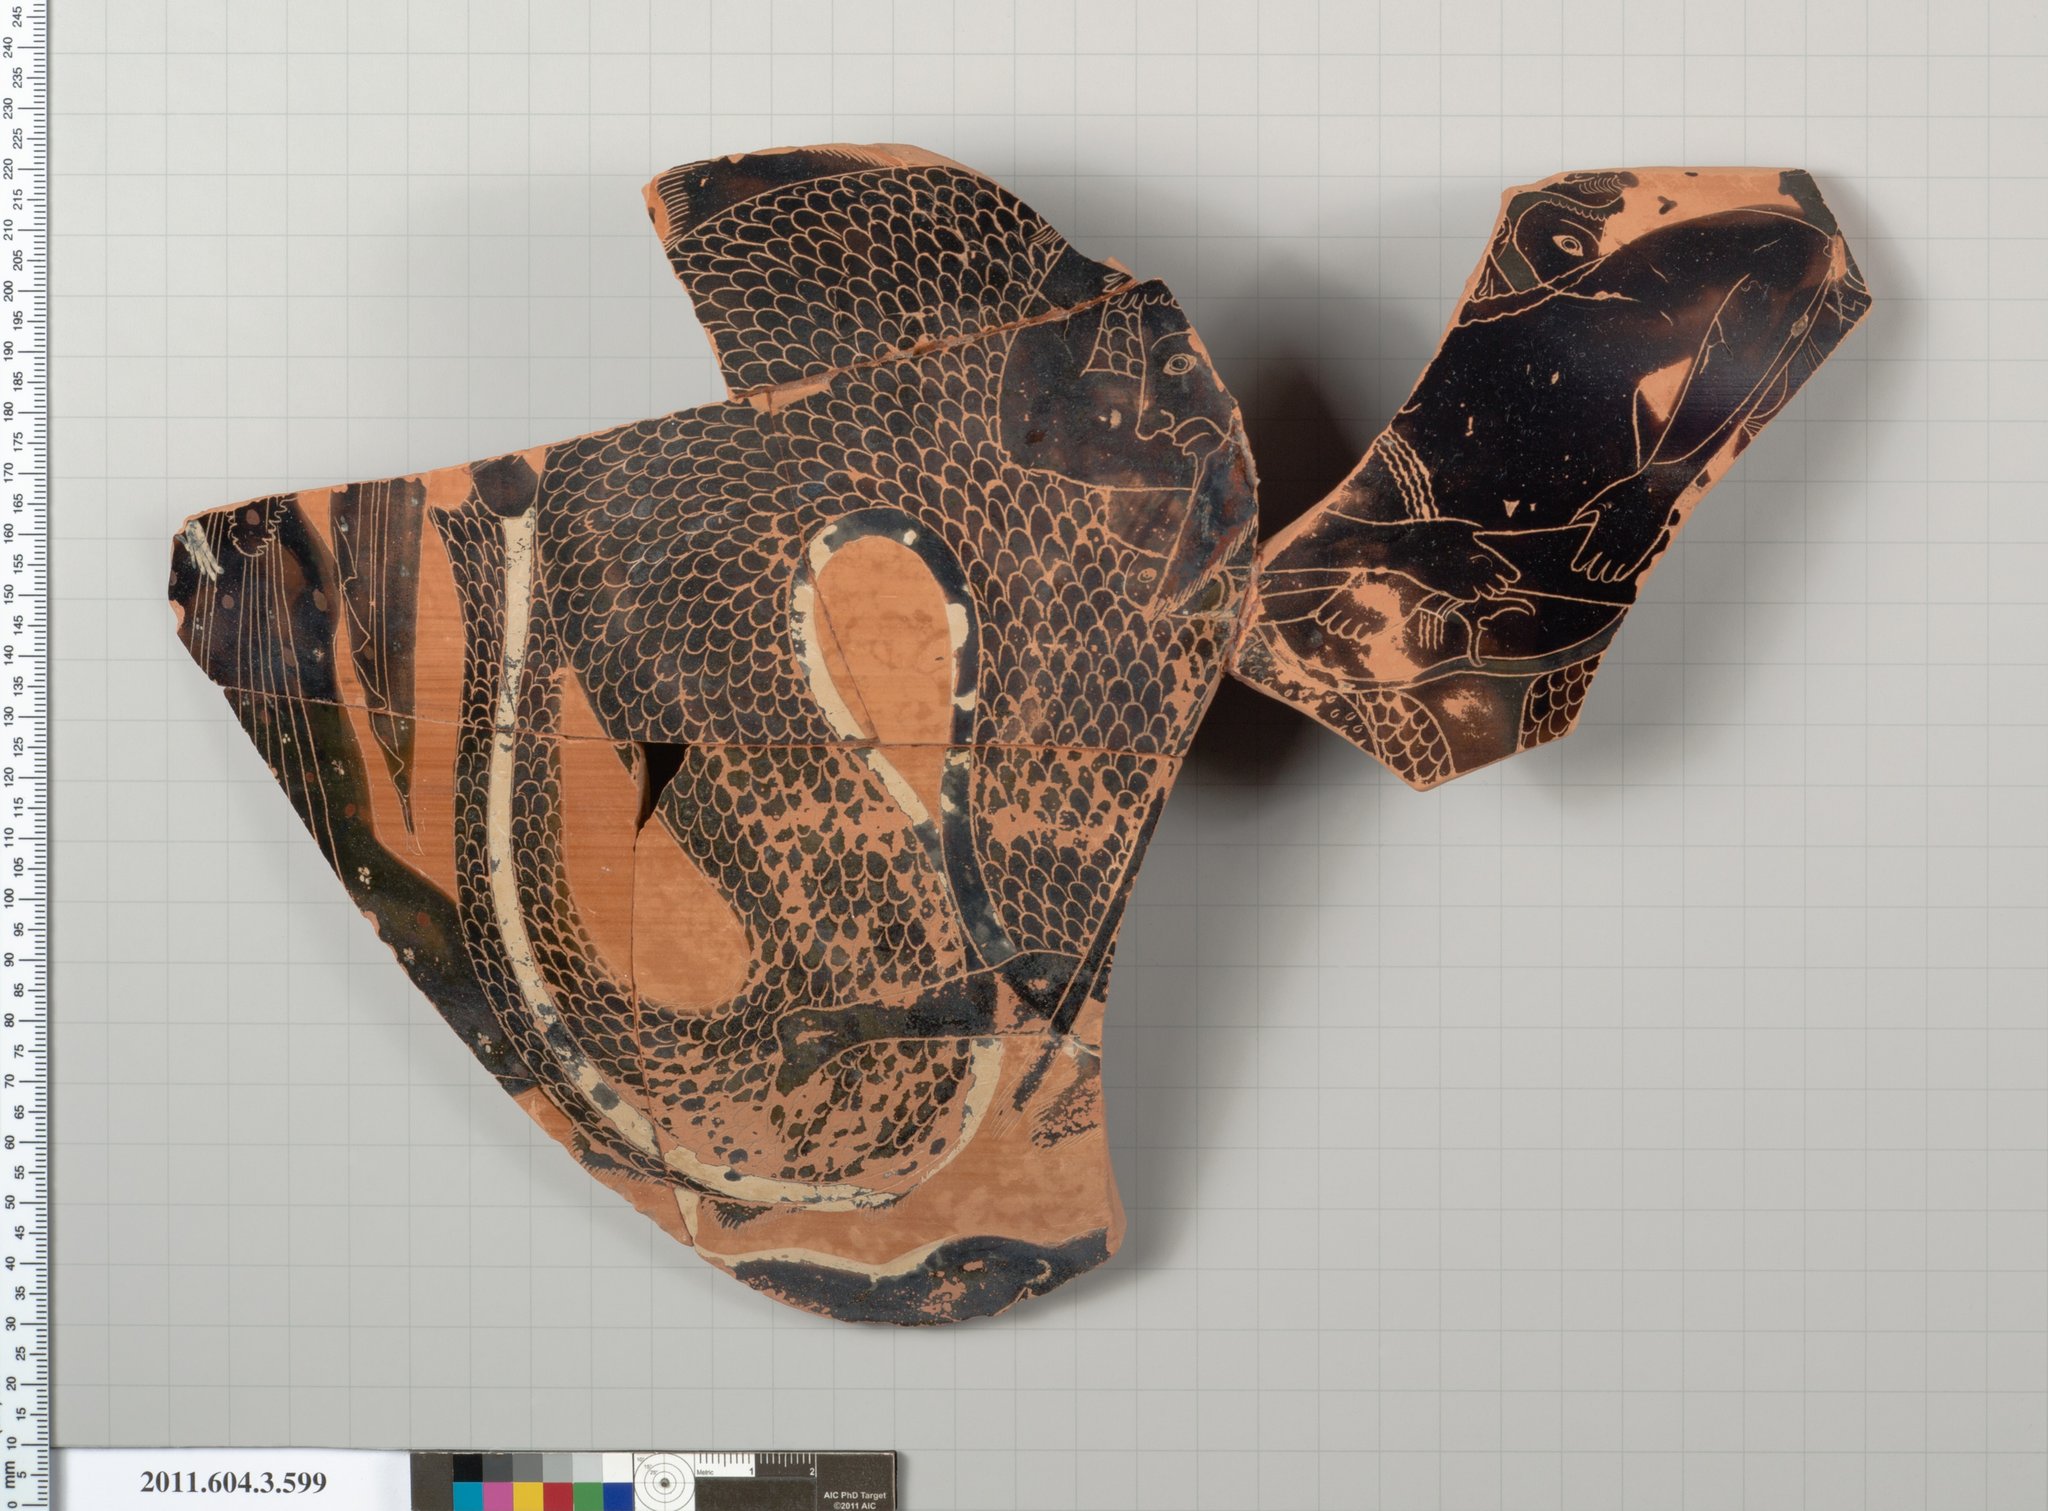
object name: column krater fragment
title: Terracotta fragment of a column-krater (bowl for mixing wine and water)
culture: greek, attic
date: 550-526 BCE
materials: terracotta